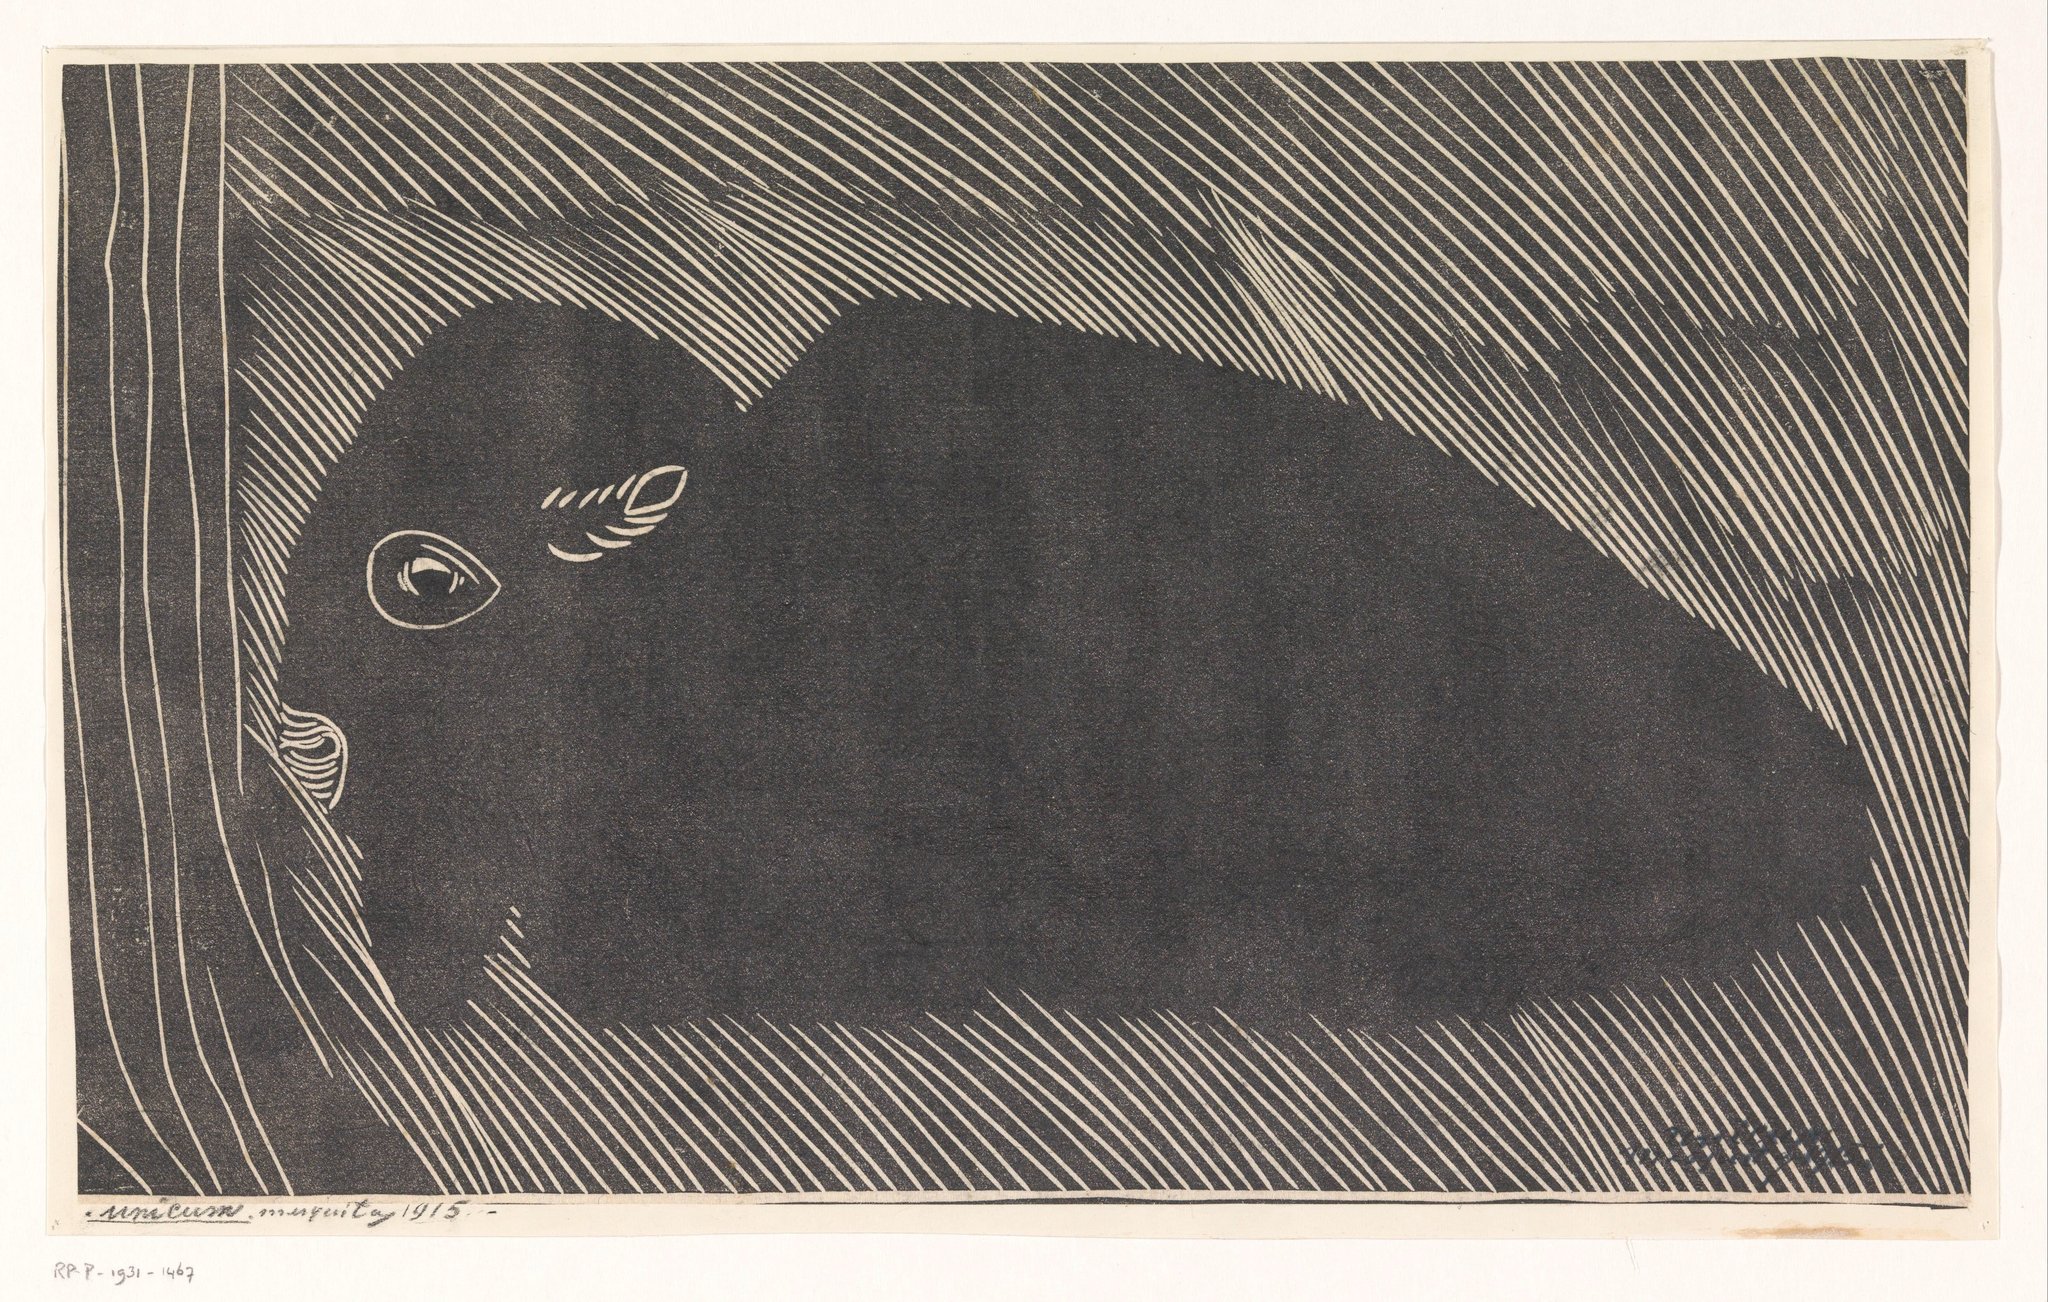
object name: print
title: Liggende bizon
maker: samuel jessurun de mesquita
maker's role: draughtsman, print maker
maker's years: 1868-1944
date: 1915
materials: paper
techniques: woodcut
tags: hoofed animals: bison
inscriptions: collector's mark: Lugt 2228, : ‘unicum Mesquita 1915’